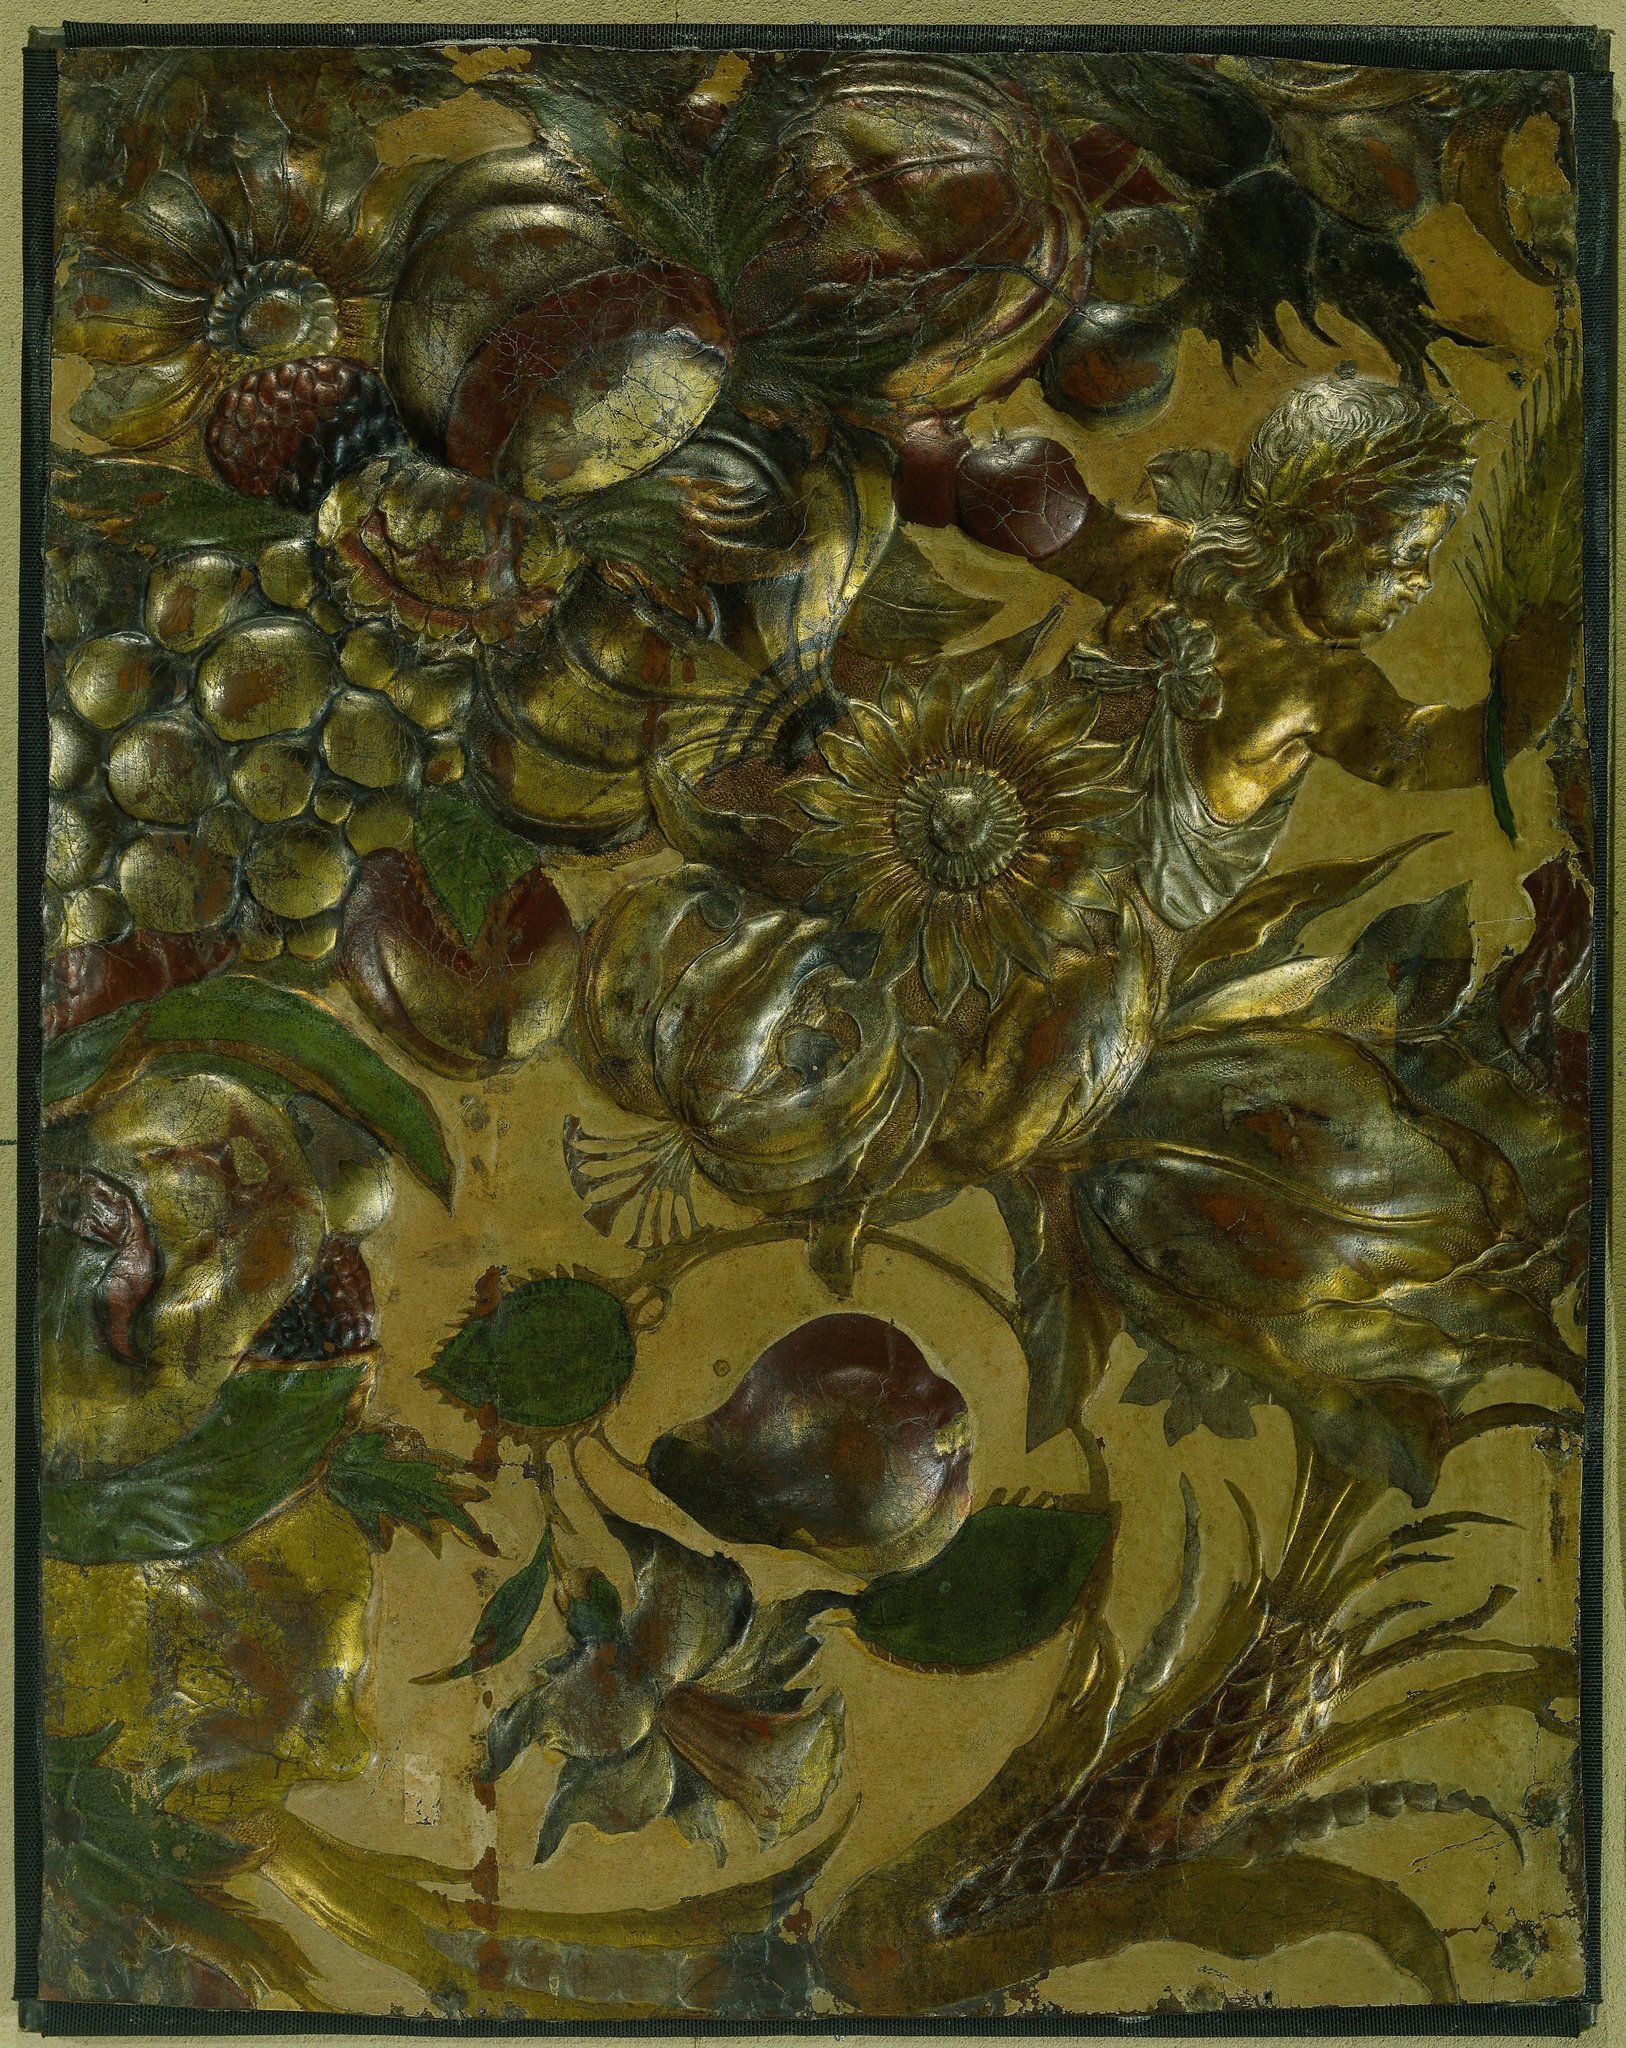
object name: upholstered wall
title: Fragment goudleer met in reliëf geperst ornament met ranken, bloemen, vruchten en een putto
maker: Anonymous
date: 1650-1675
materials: gilt leather, leather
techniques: painted, pressing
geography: northern netherlands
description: Een fragment in reliëf geperst goudleer. Op een crème fond zijn ranken, bloemen, vruchten en een putto in goud en kleuren aangebracht. Het patroon is identiek aan BK-Br-381 en BK-18243. Het betreft hier een detail uit een vel; het volledige patroon bestaat uit voluutvormige ranken, bloemen, vruchten, vlinders, twee putti en een papegaai.